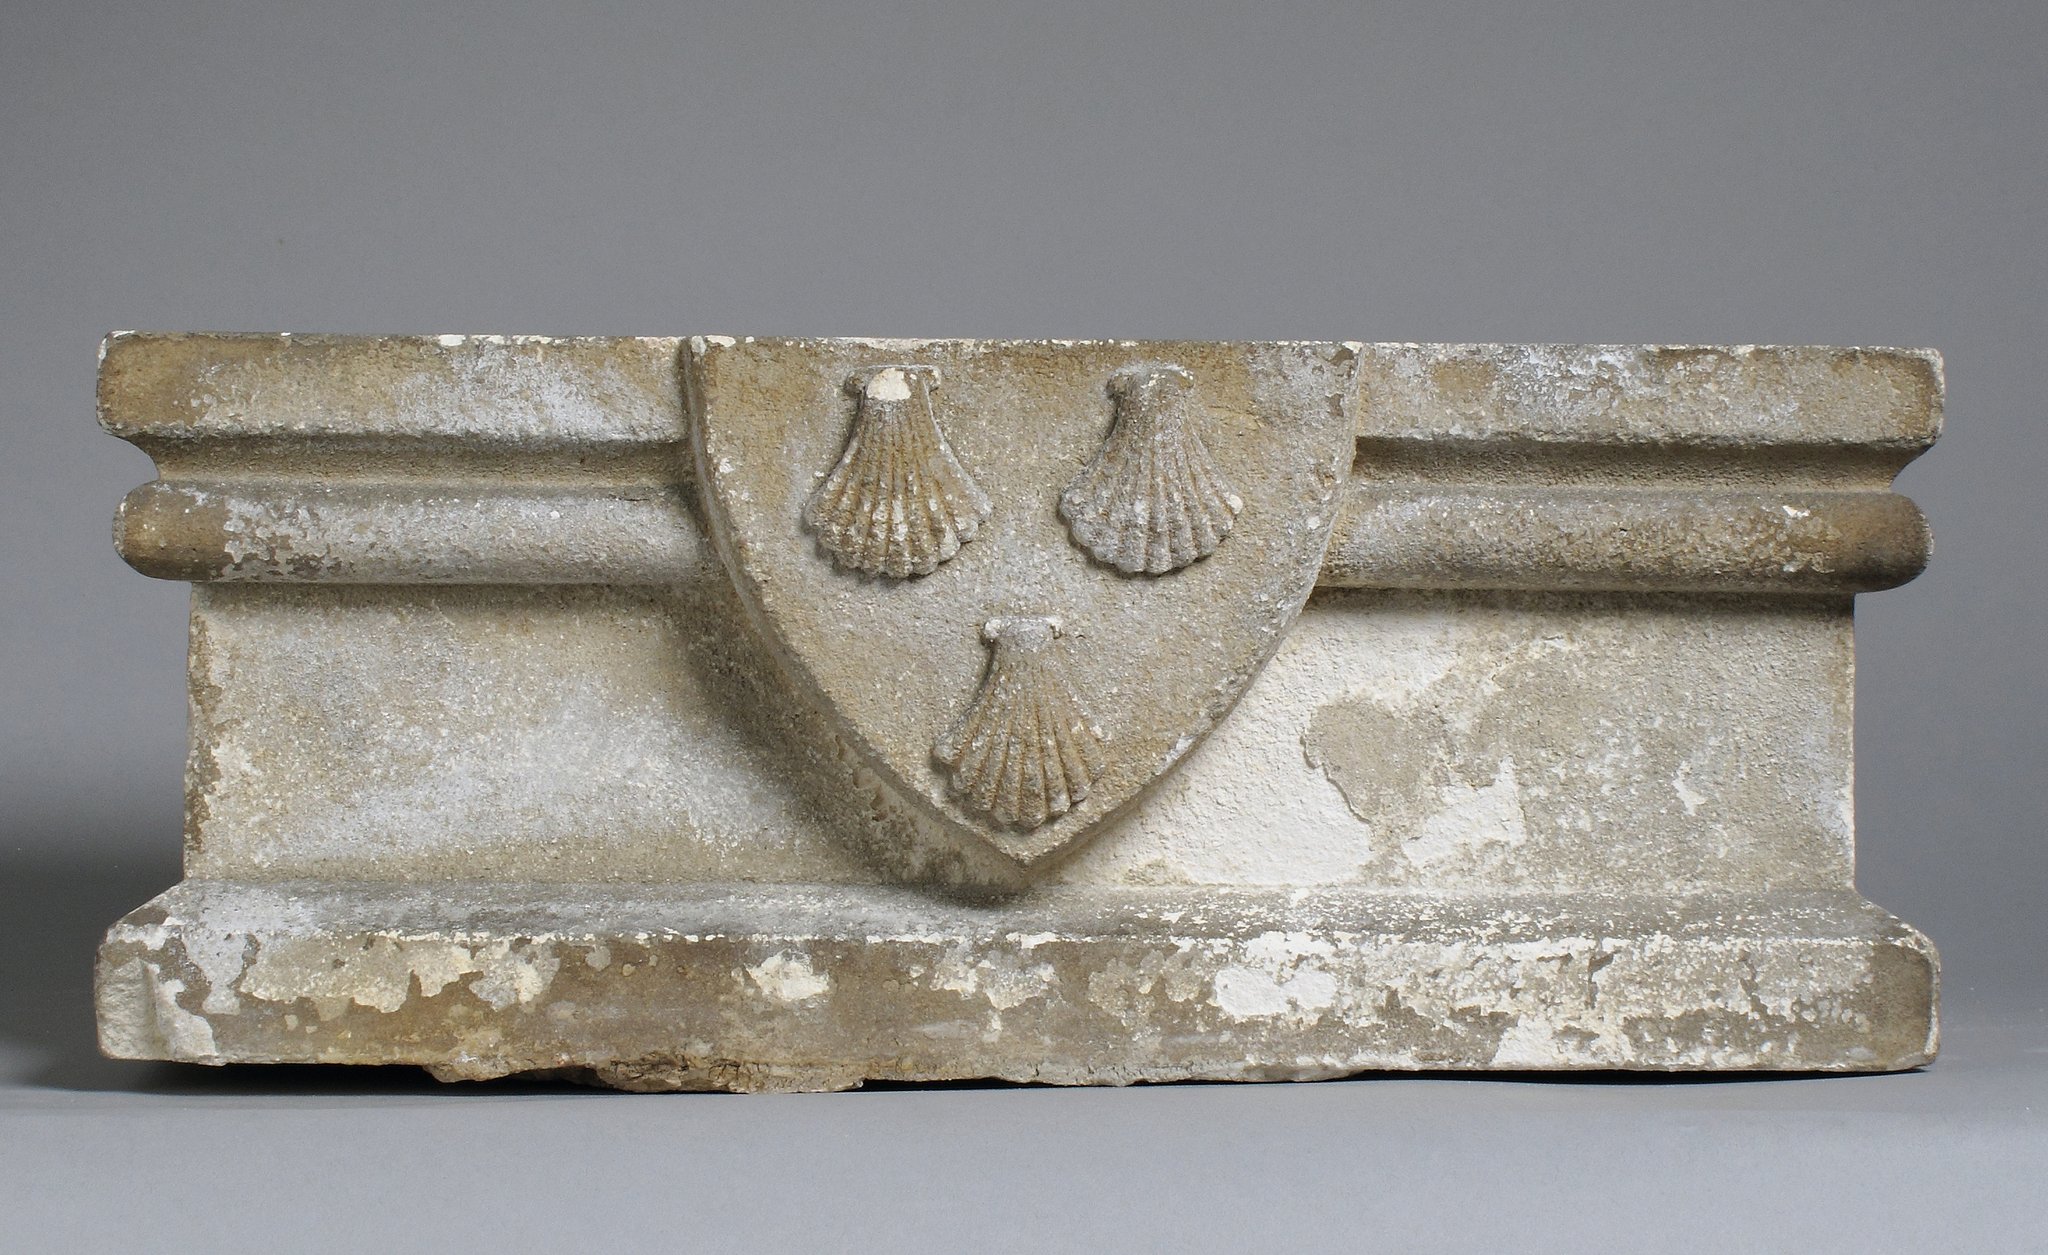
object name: column base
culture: french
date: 1467-1533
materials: limestone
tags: shells